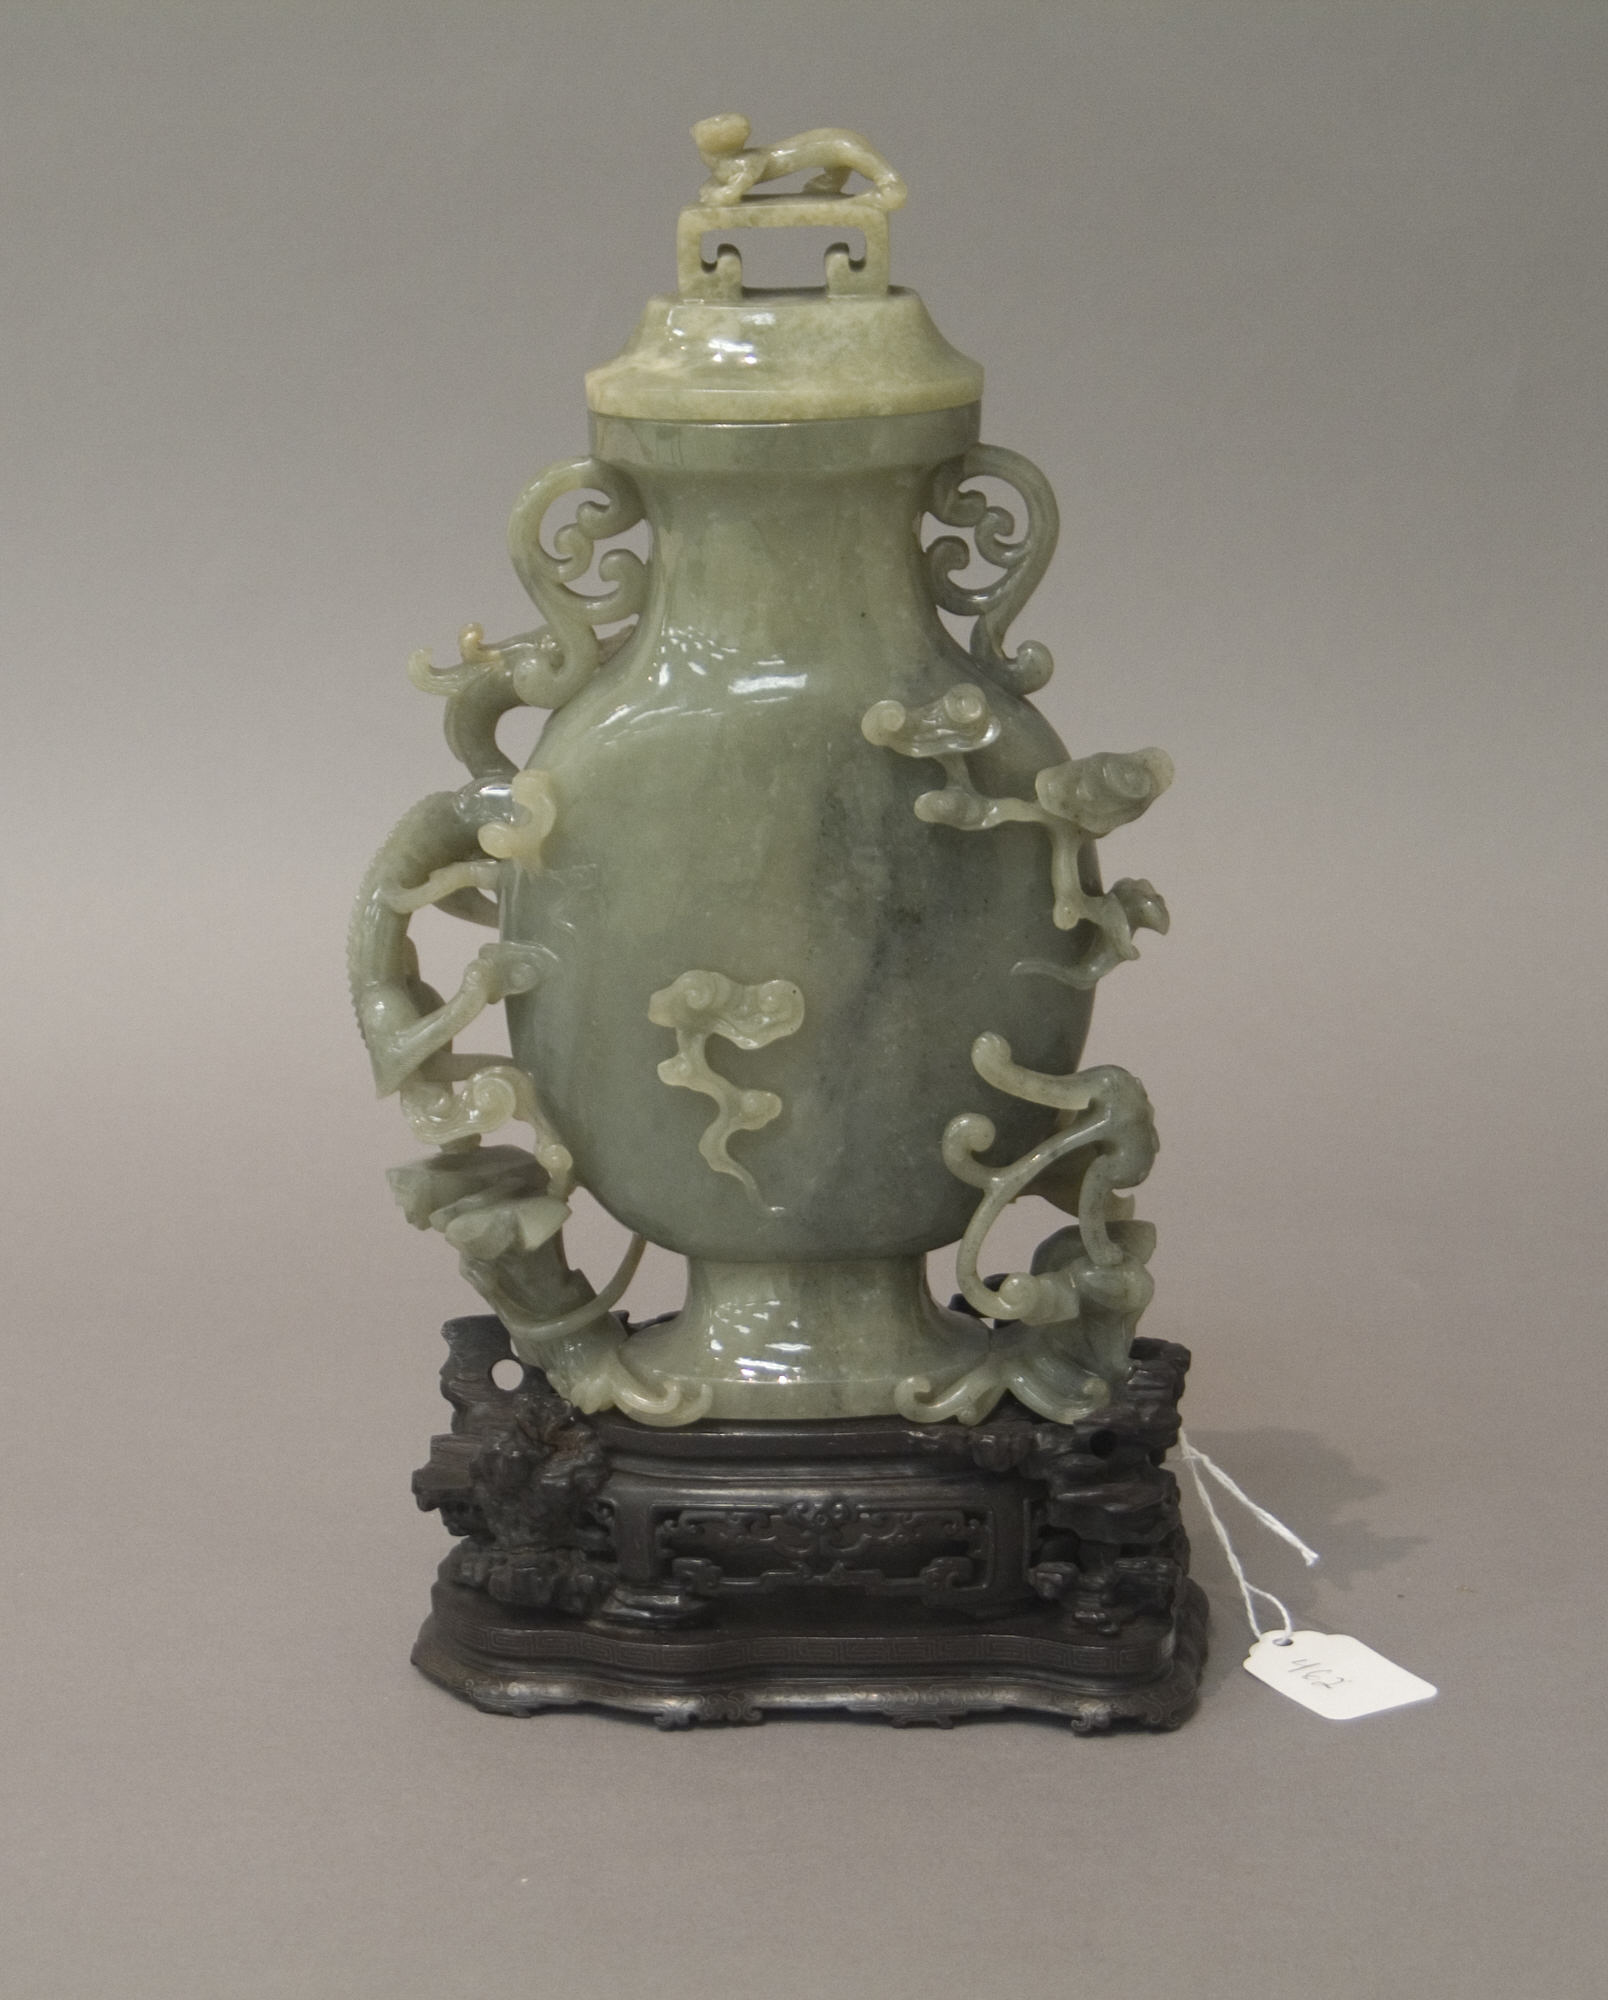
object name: vase with cover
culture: chinese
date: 1662-1722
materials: jade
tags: dragons